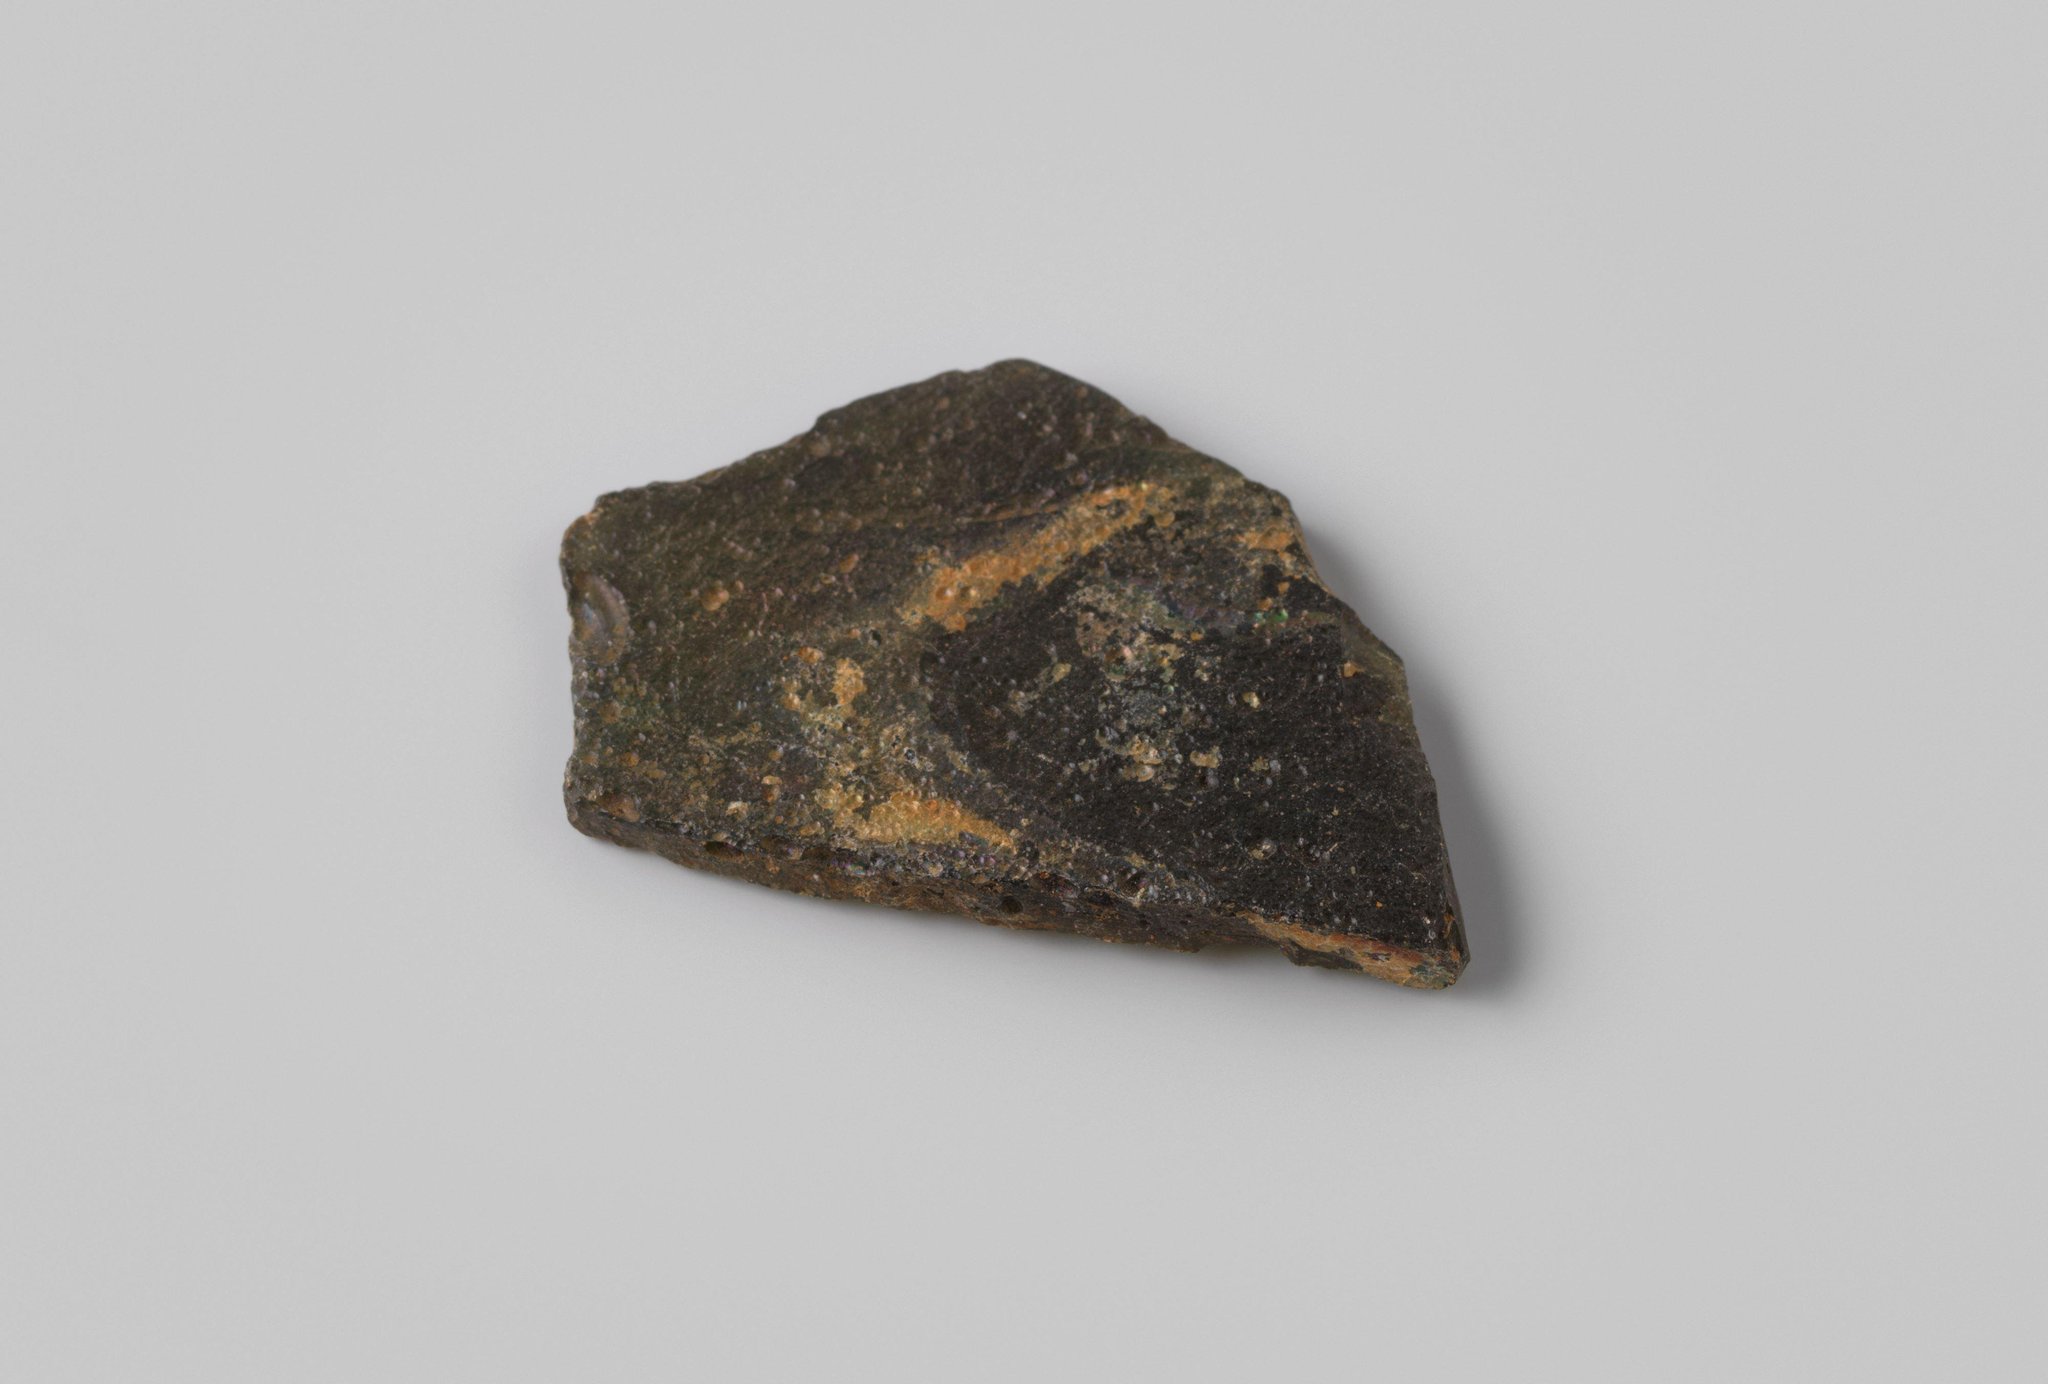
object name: sherd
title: Scherf van een wijnfles uit het wrak van de Oost-Indiëvaarder Hollandia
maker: Anonymous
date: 1700-1743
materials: glass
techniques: green glass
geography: netherlands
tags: verenigde oostindische compagnie, hollandia (schip)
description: Typologically not identifiable, flat fragment, fragment.